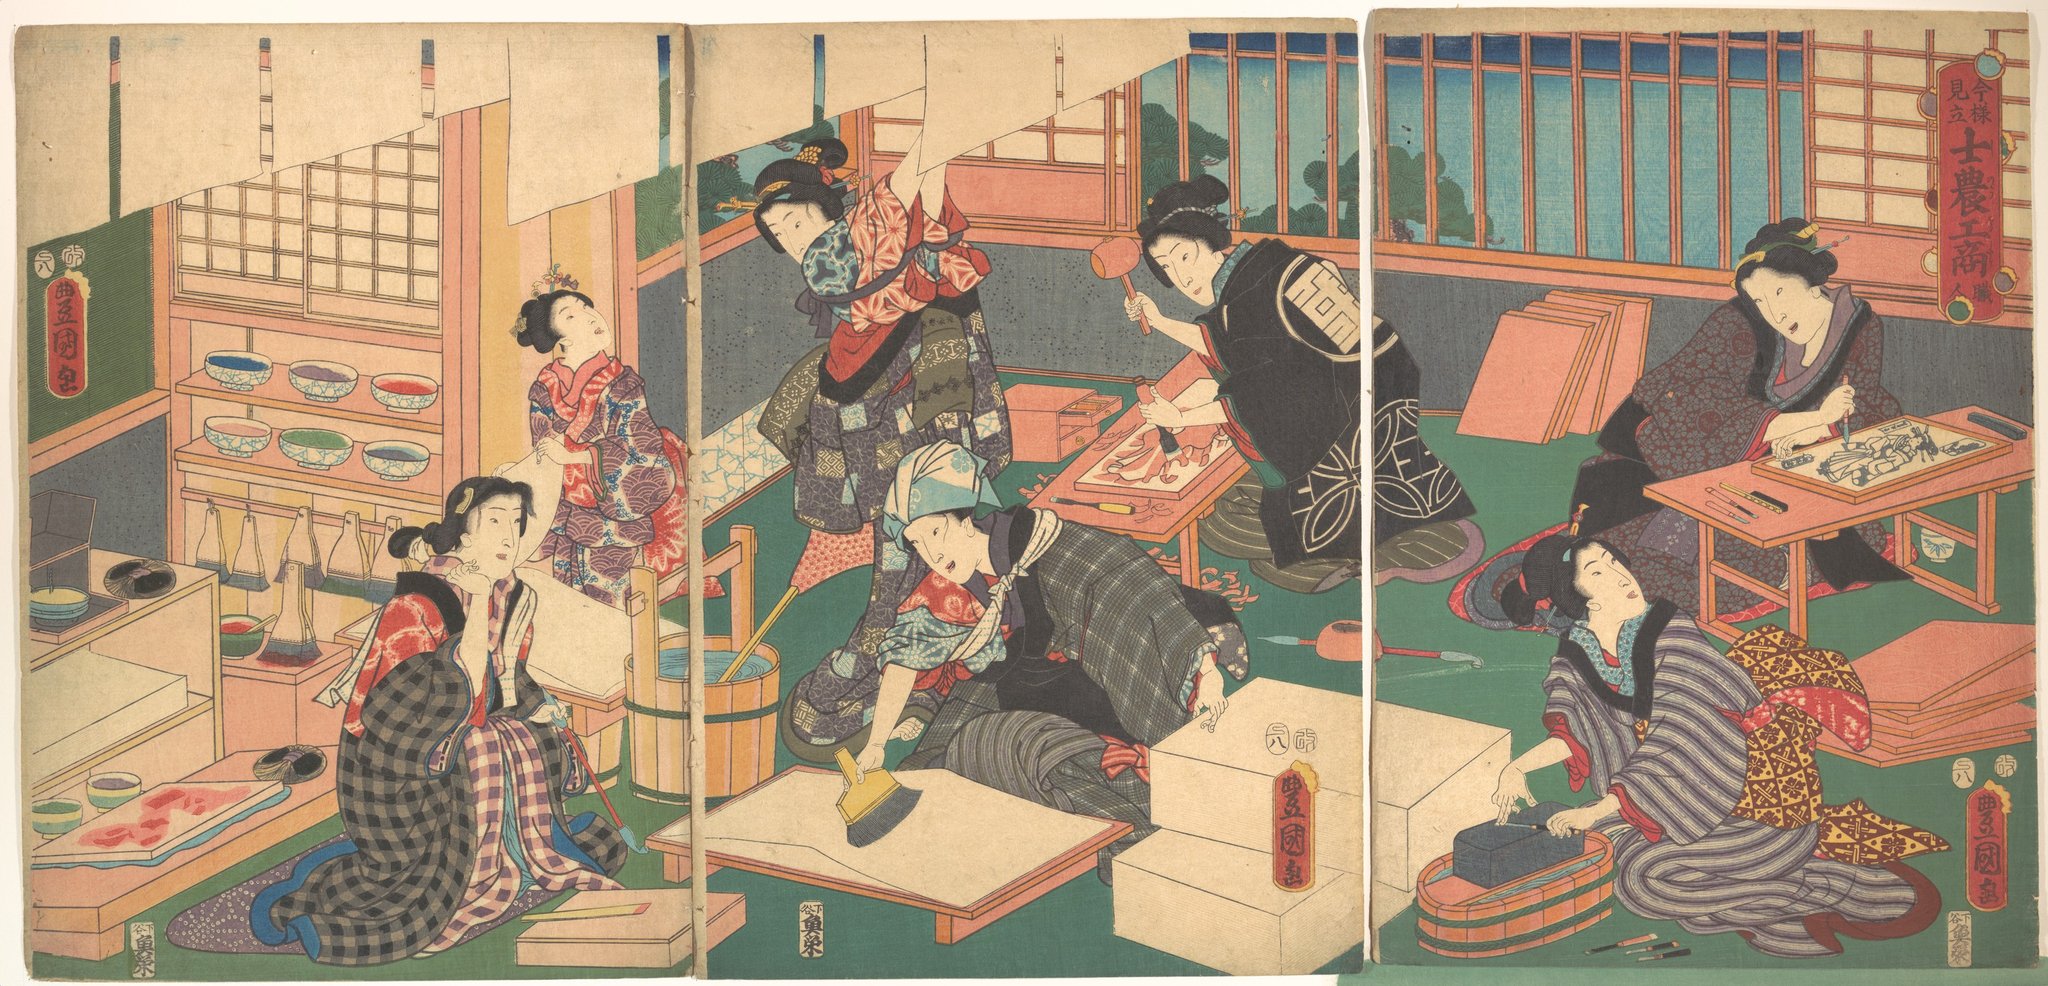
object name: print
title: Artisans, from the series "An Up-to-Date Parody of the Four Classes"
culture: japanese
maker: utagawa kunisada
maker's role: artist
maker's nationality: japanese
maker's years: 1786-1864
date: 1801-1900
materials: ink, paper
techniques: woodblock print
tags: women,working